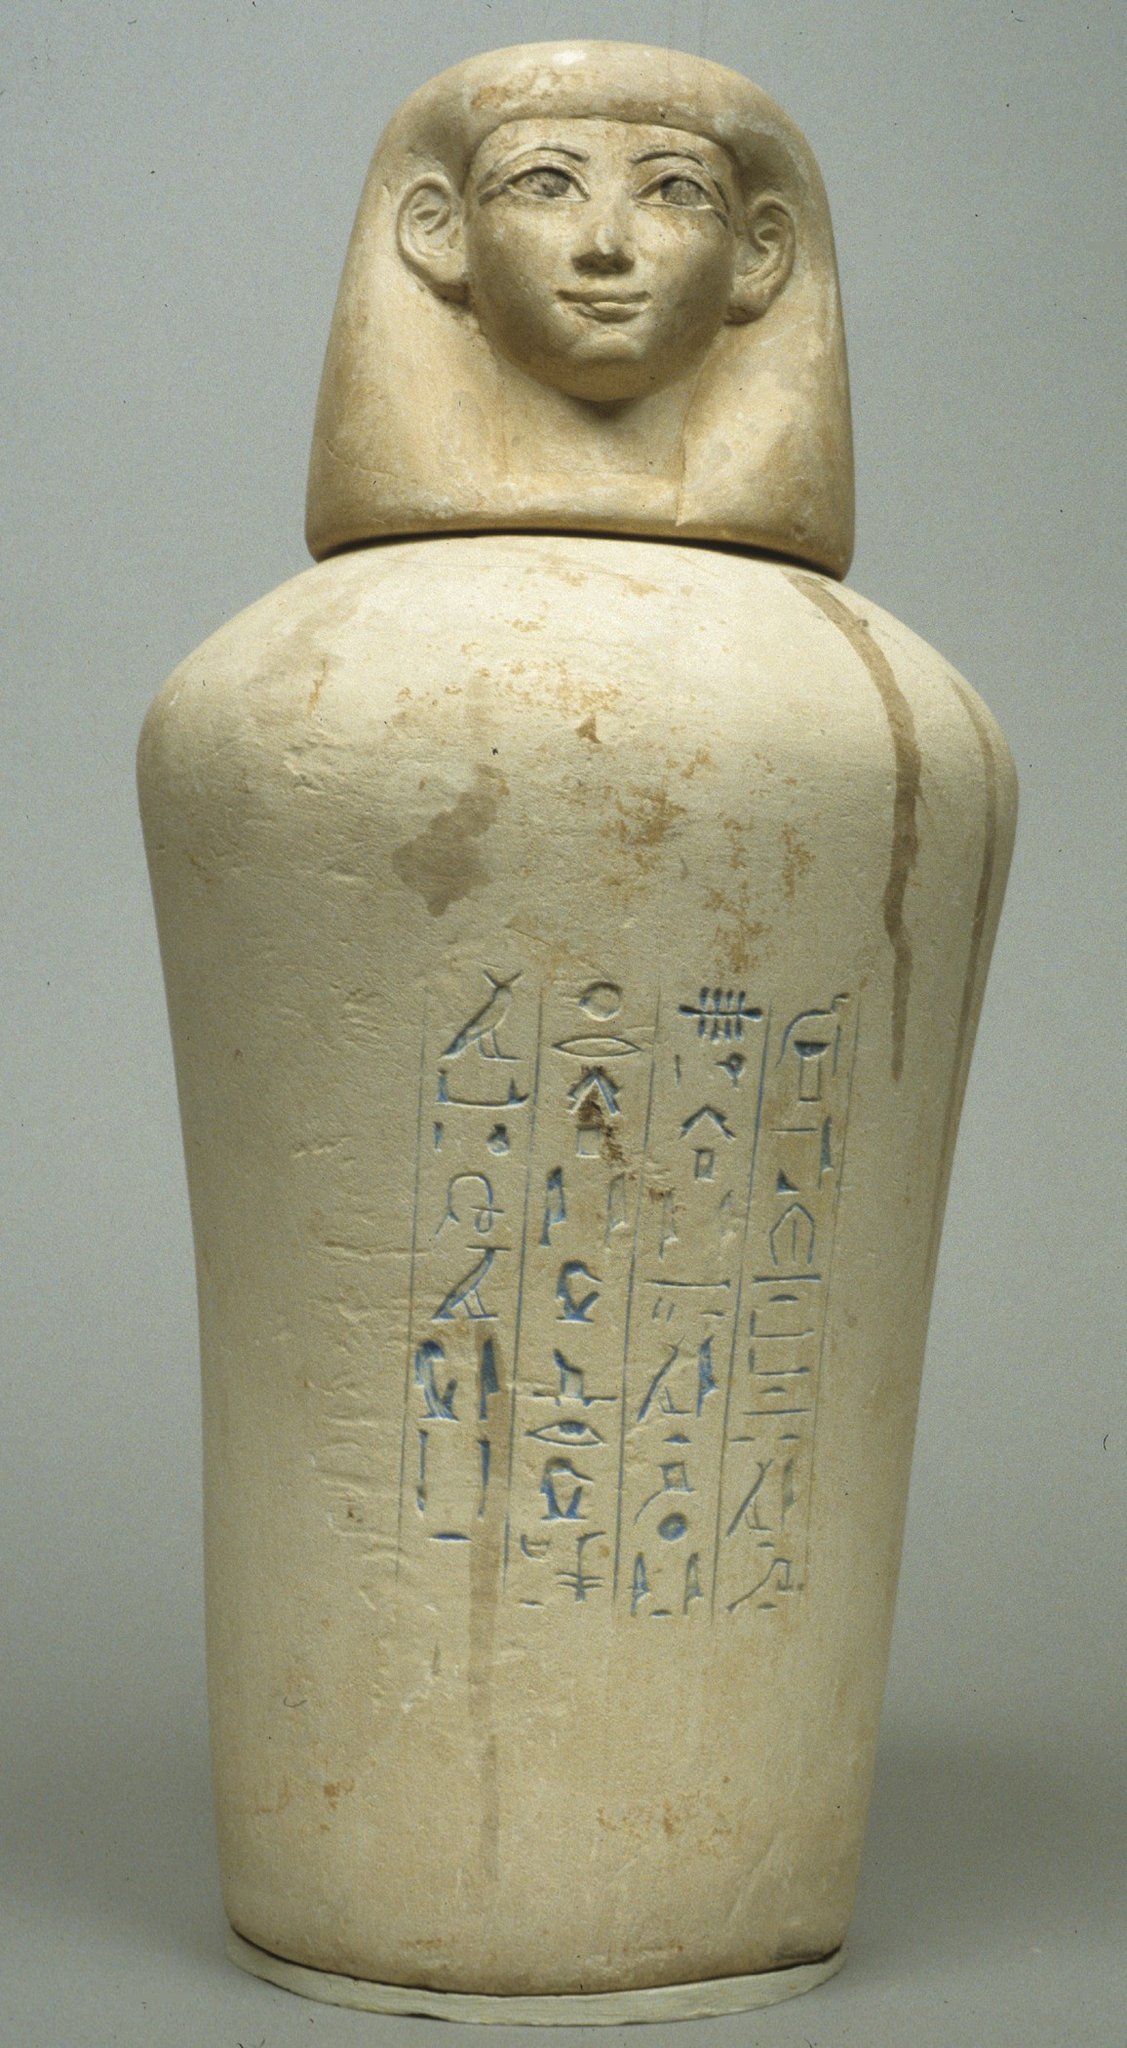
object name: canopic jar, manuwai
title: Canopic Jar of Manuwai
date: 1479-1425 BCE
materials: limestone, paste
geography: egypt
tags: hieroglyphs